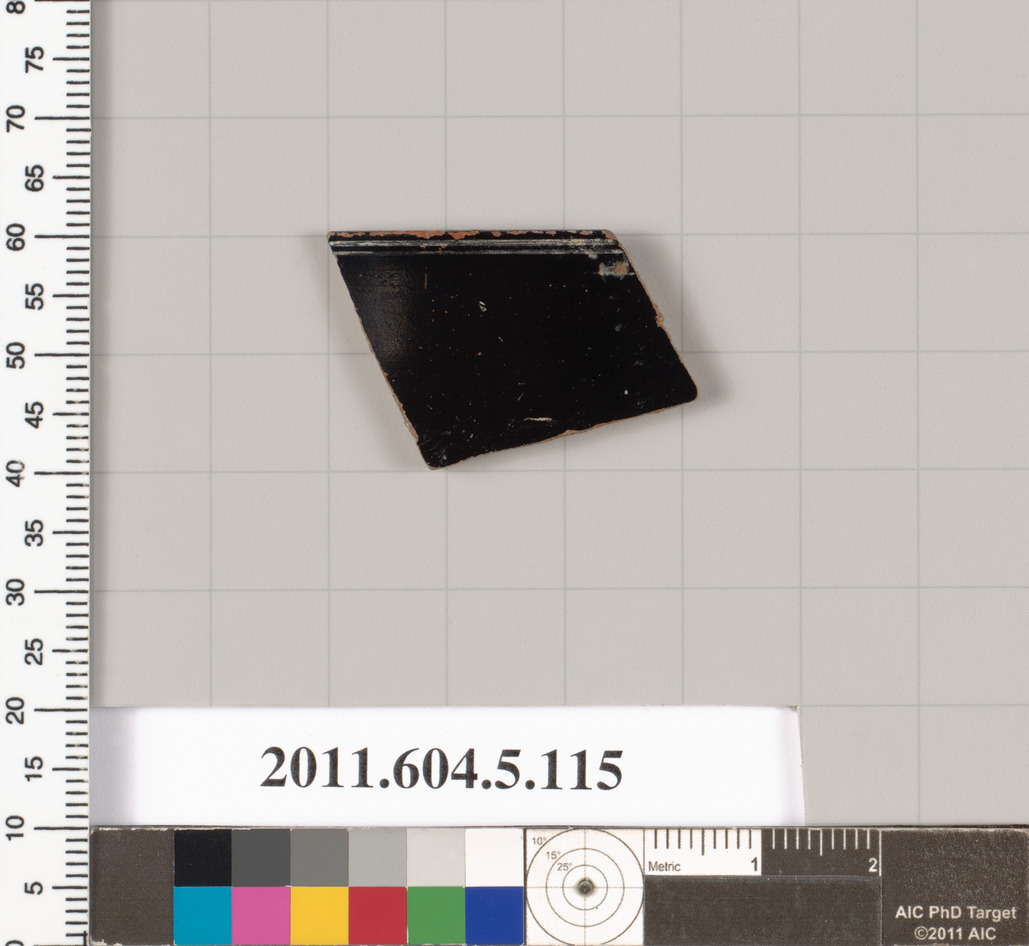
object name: kylix fragment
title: Terracotta rim fragment of a stemless kylix (drinking cup)?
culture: greek, attic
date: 470-450 BCE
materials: terracotta